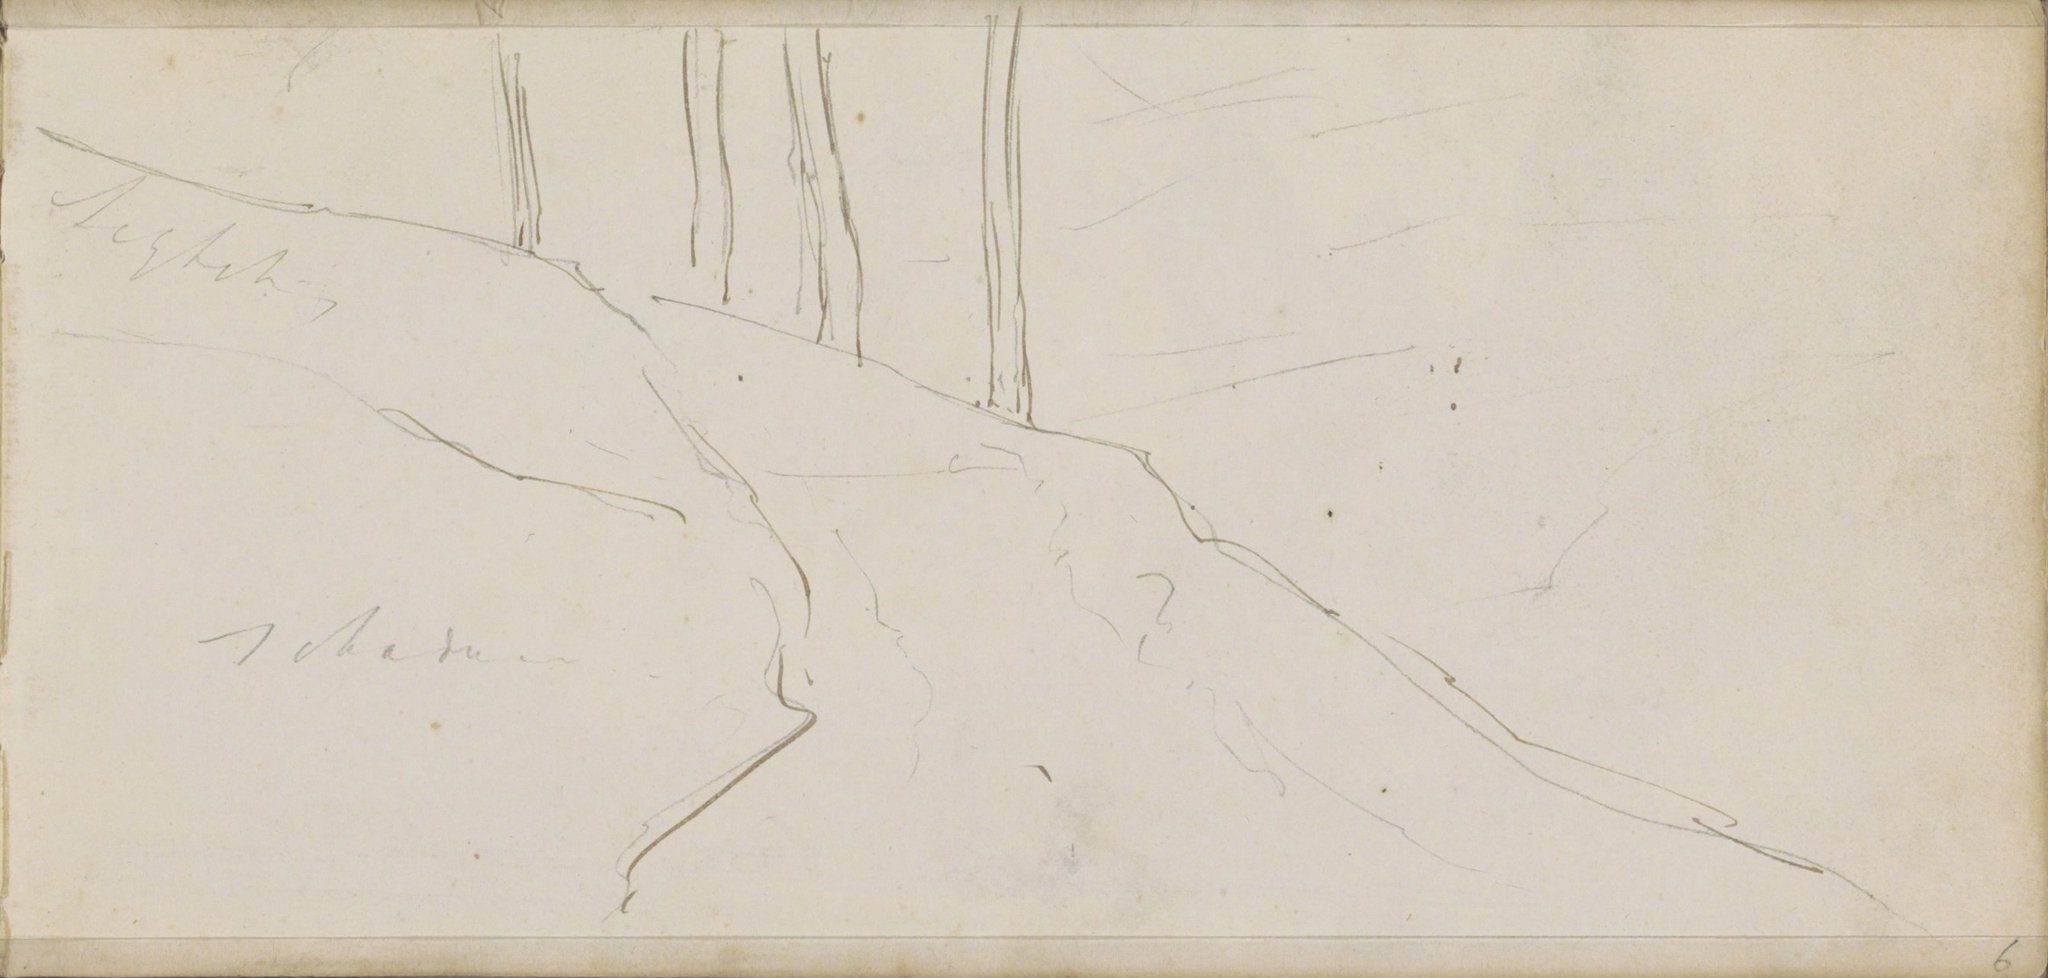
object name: sketchbook leaf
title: Bomen op een heuvel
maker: johannes tavenraat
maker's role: draughtsman, painter, print maker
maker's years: 1809-1881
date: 1840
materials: ink, paper, pencil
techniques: pen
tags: trees, (high) hill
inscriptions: kleurnotitie, handgeschreven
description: Blad 6 recto uit een schetsboek met 63 bladen.